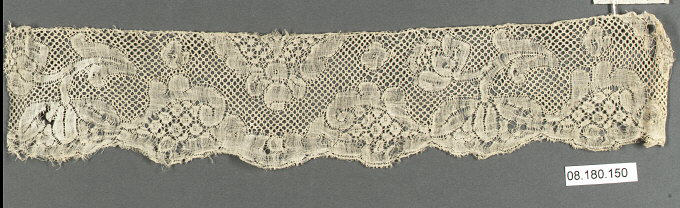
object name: piece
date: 1701-1800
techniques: lace